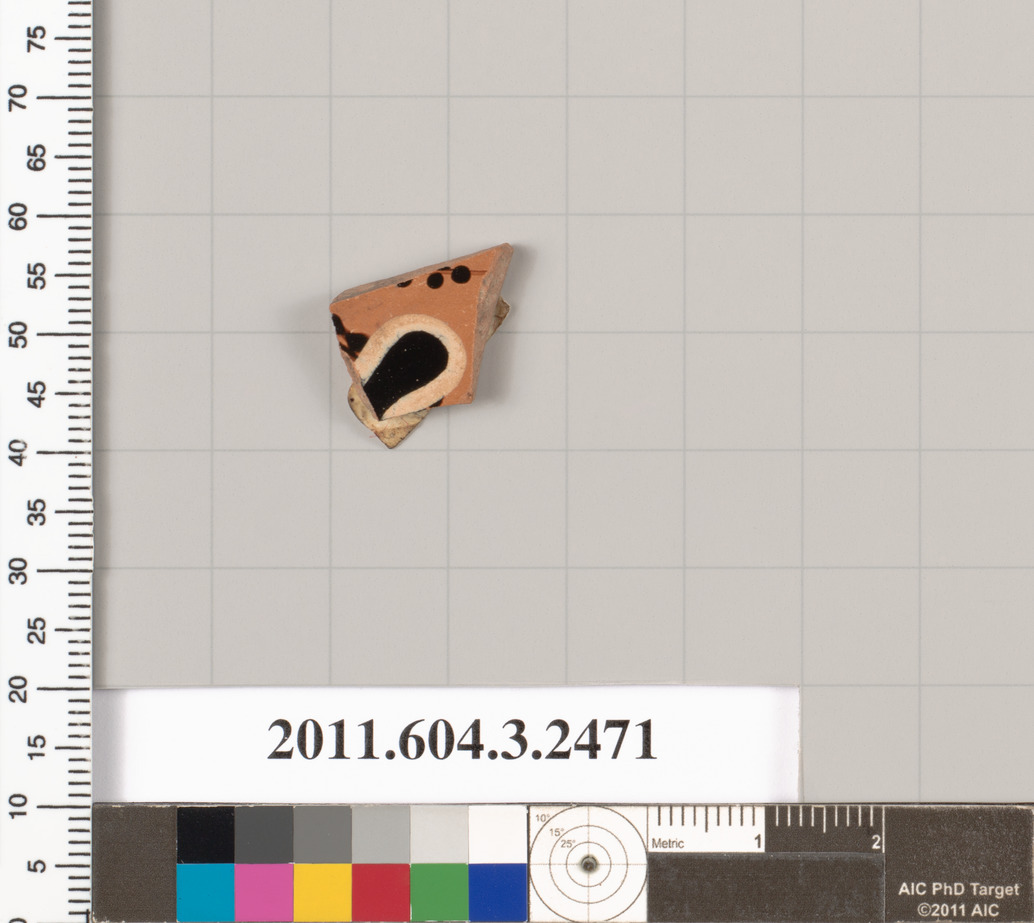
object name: kylix fragment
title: Terracotta fragment of a kylix: eye-cup (drinking cup)?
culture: greek, attic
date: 530-500 BCE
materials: terracotta